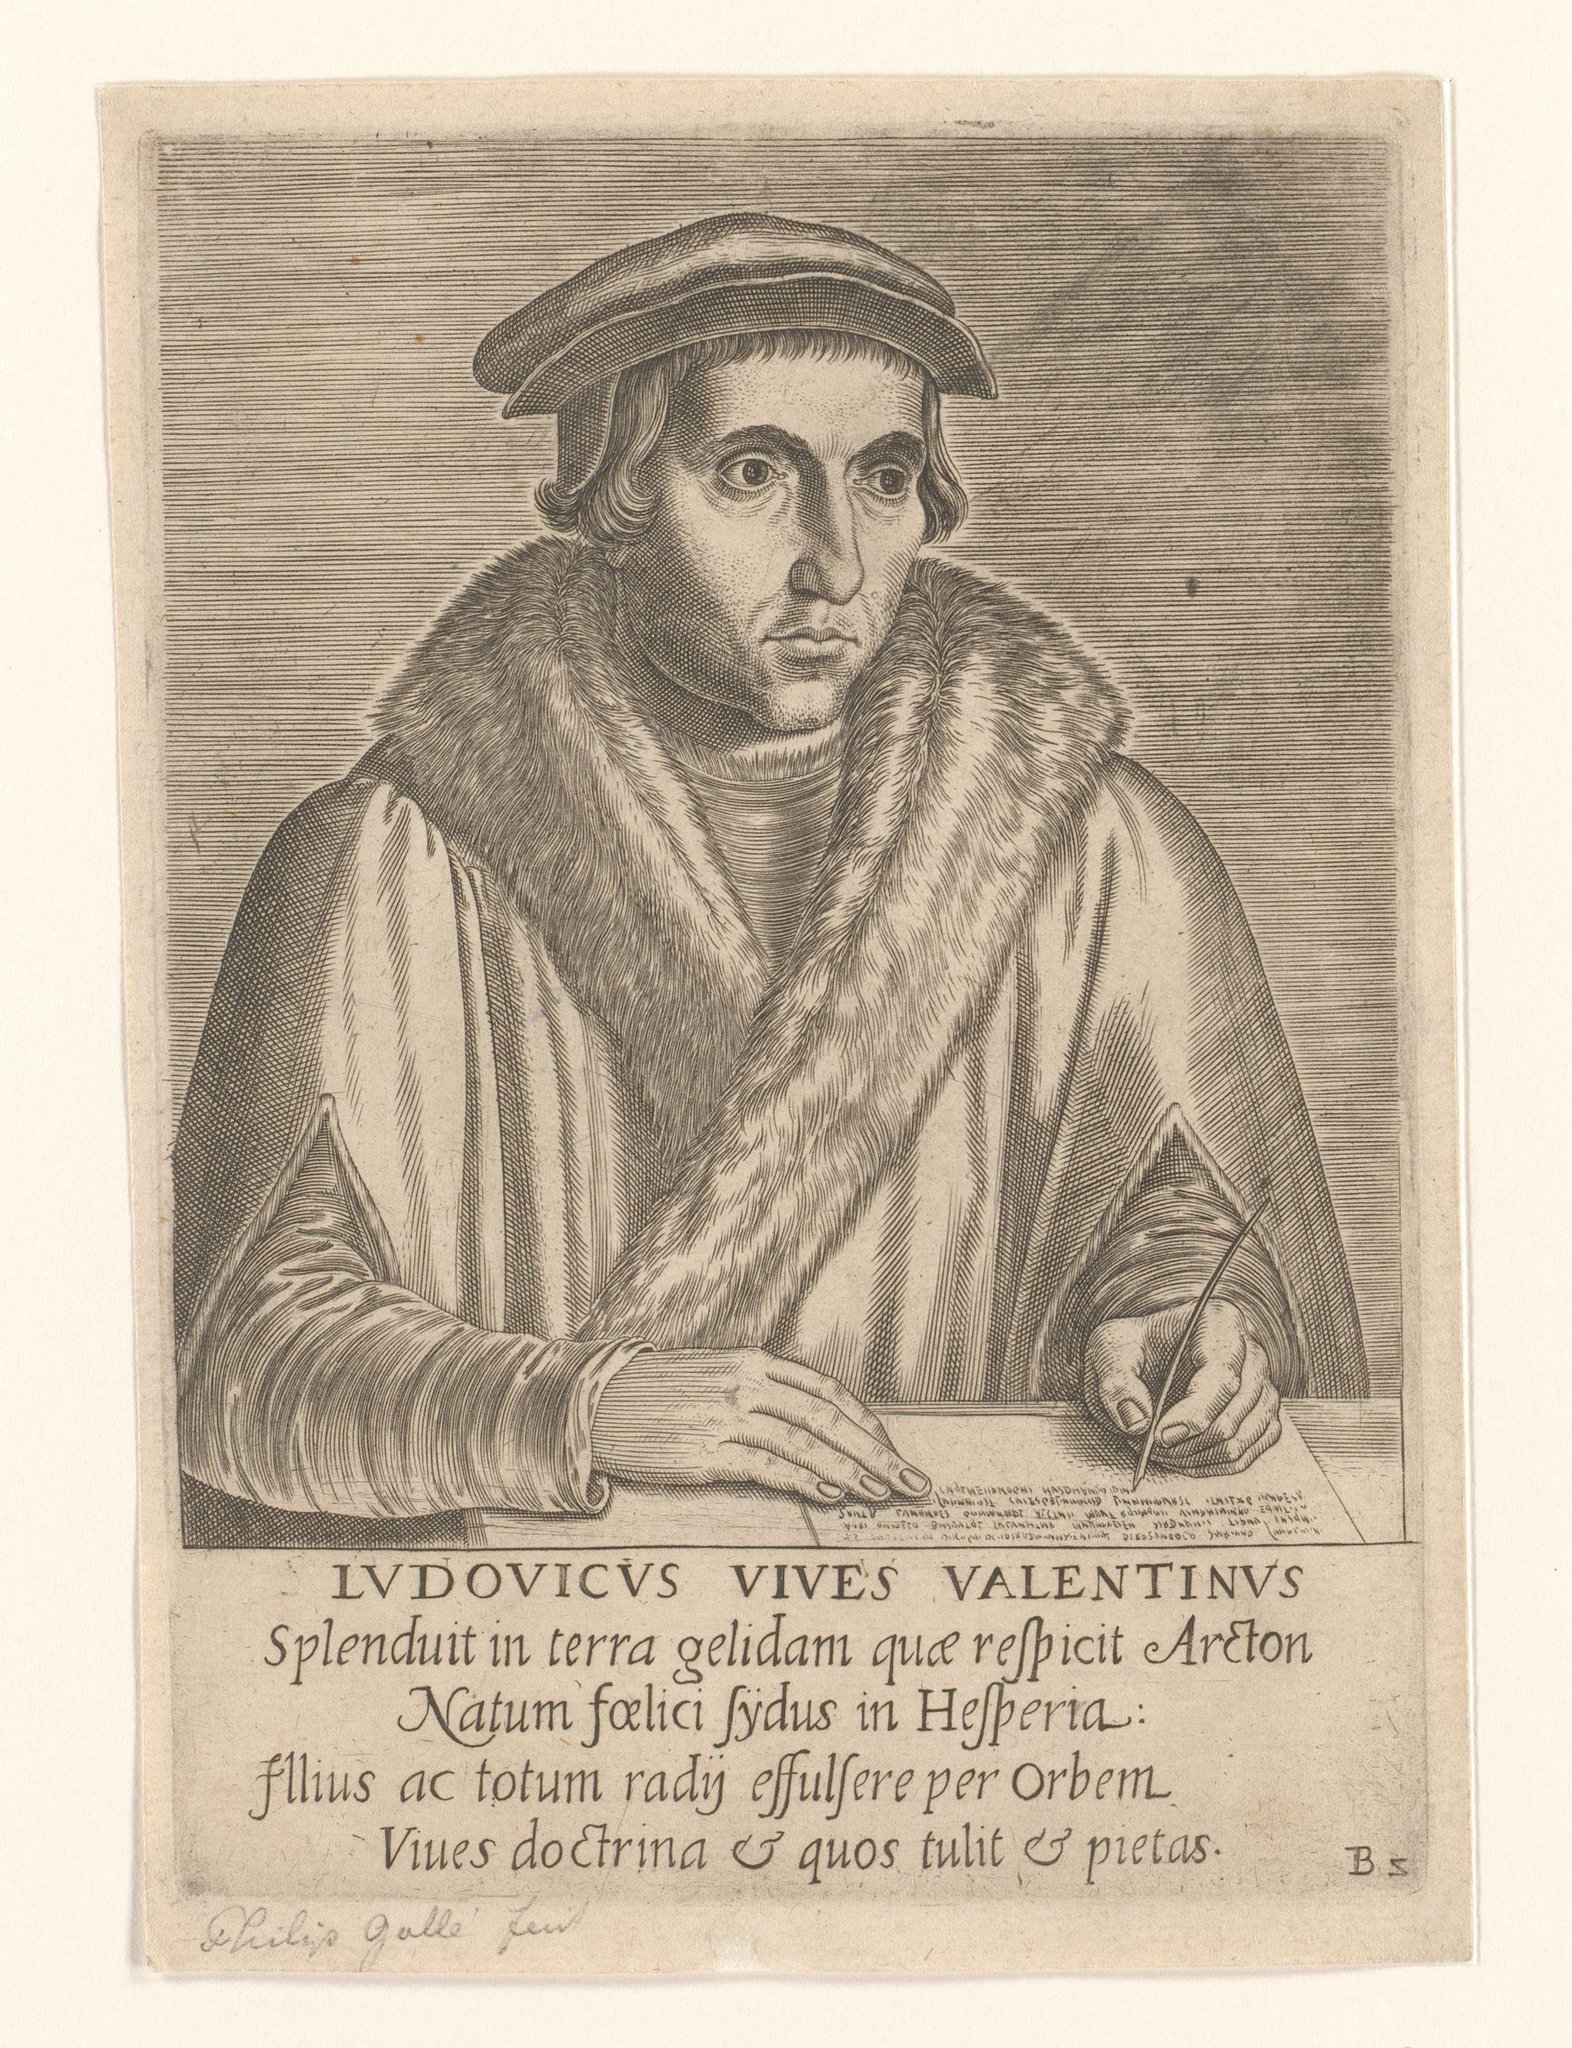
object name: print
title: Portretten van beroemde Europese geleerden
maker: philips galle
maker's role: print maker, publisher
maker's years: 1537-1612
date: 1572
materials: paper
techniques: engraving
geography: antwerp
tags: handwriting, writing as activity, historical persons, scholar, philosopher (+ portrait of scholar, scientist)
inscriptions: collector's mark: Lugt 2228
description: Met vierregelig onderschrift in het Latijn. Rechtsonder genummerd: B2 (2 als z in spiegelbeeld).